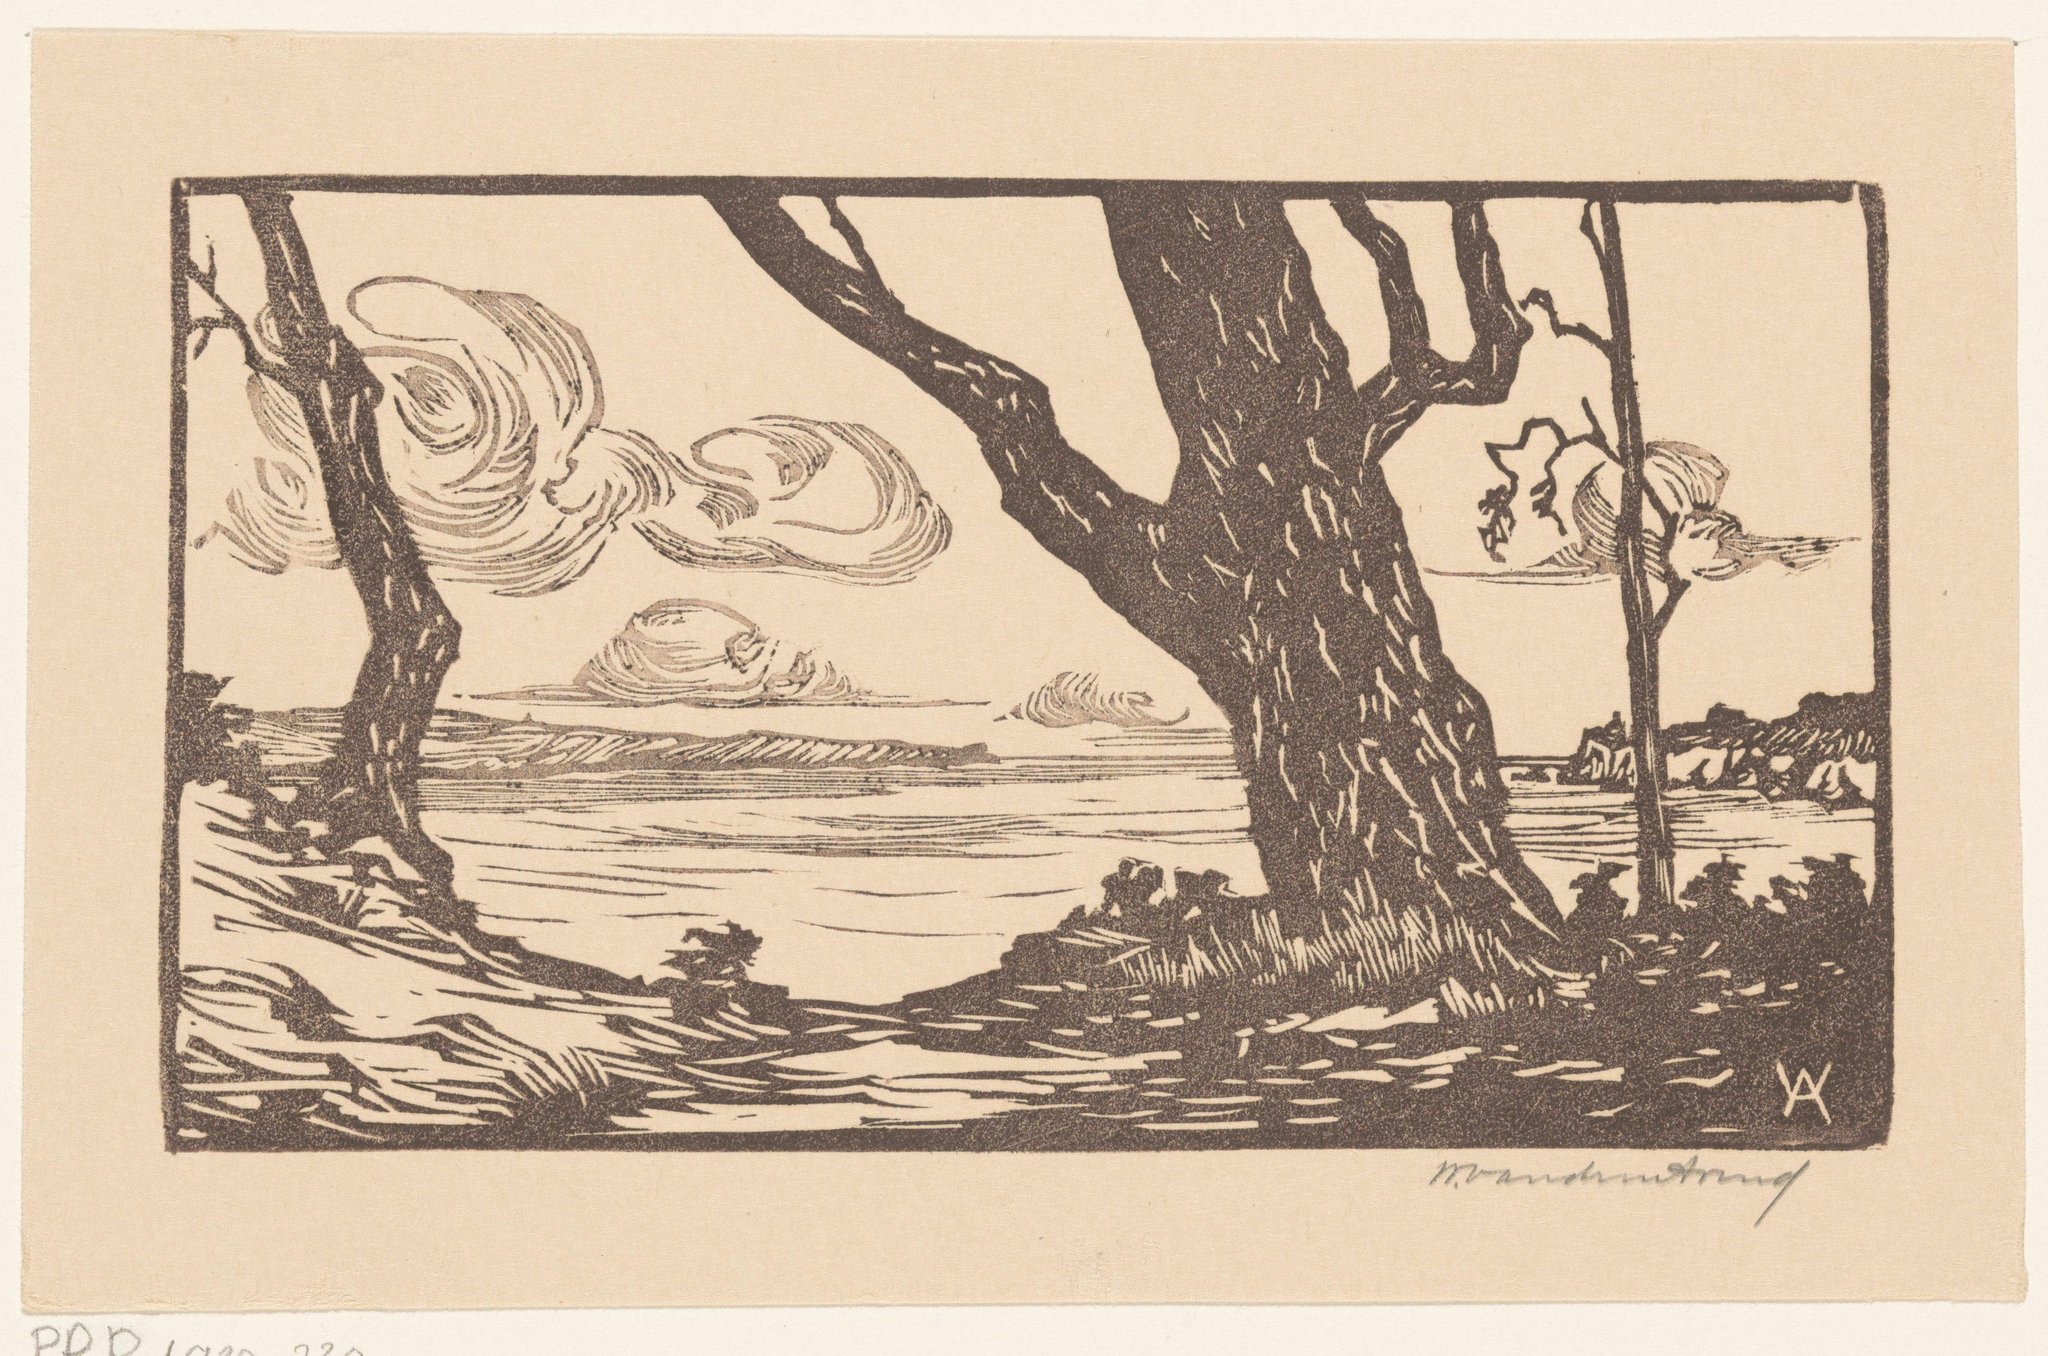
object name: print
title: Bretonse kust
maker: willem van den arend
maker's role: painter, print maker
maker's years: 1875-1954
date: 1885-1930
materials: paper, ink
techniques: woodcut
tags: rocky coast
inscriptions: collector's mark: Lugt 2228, monogram: ‘AW’, signature: ‘W.vandenArend’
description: Kustgezicht met op de voorgrond drie bomen.